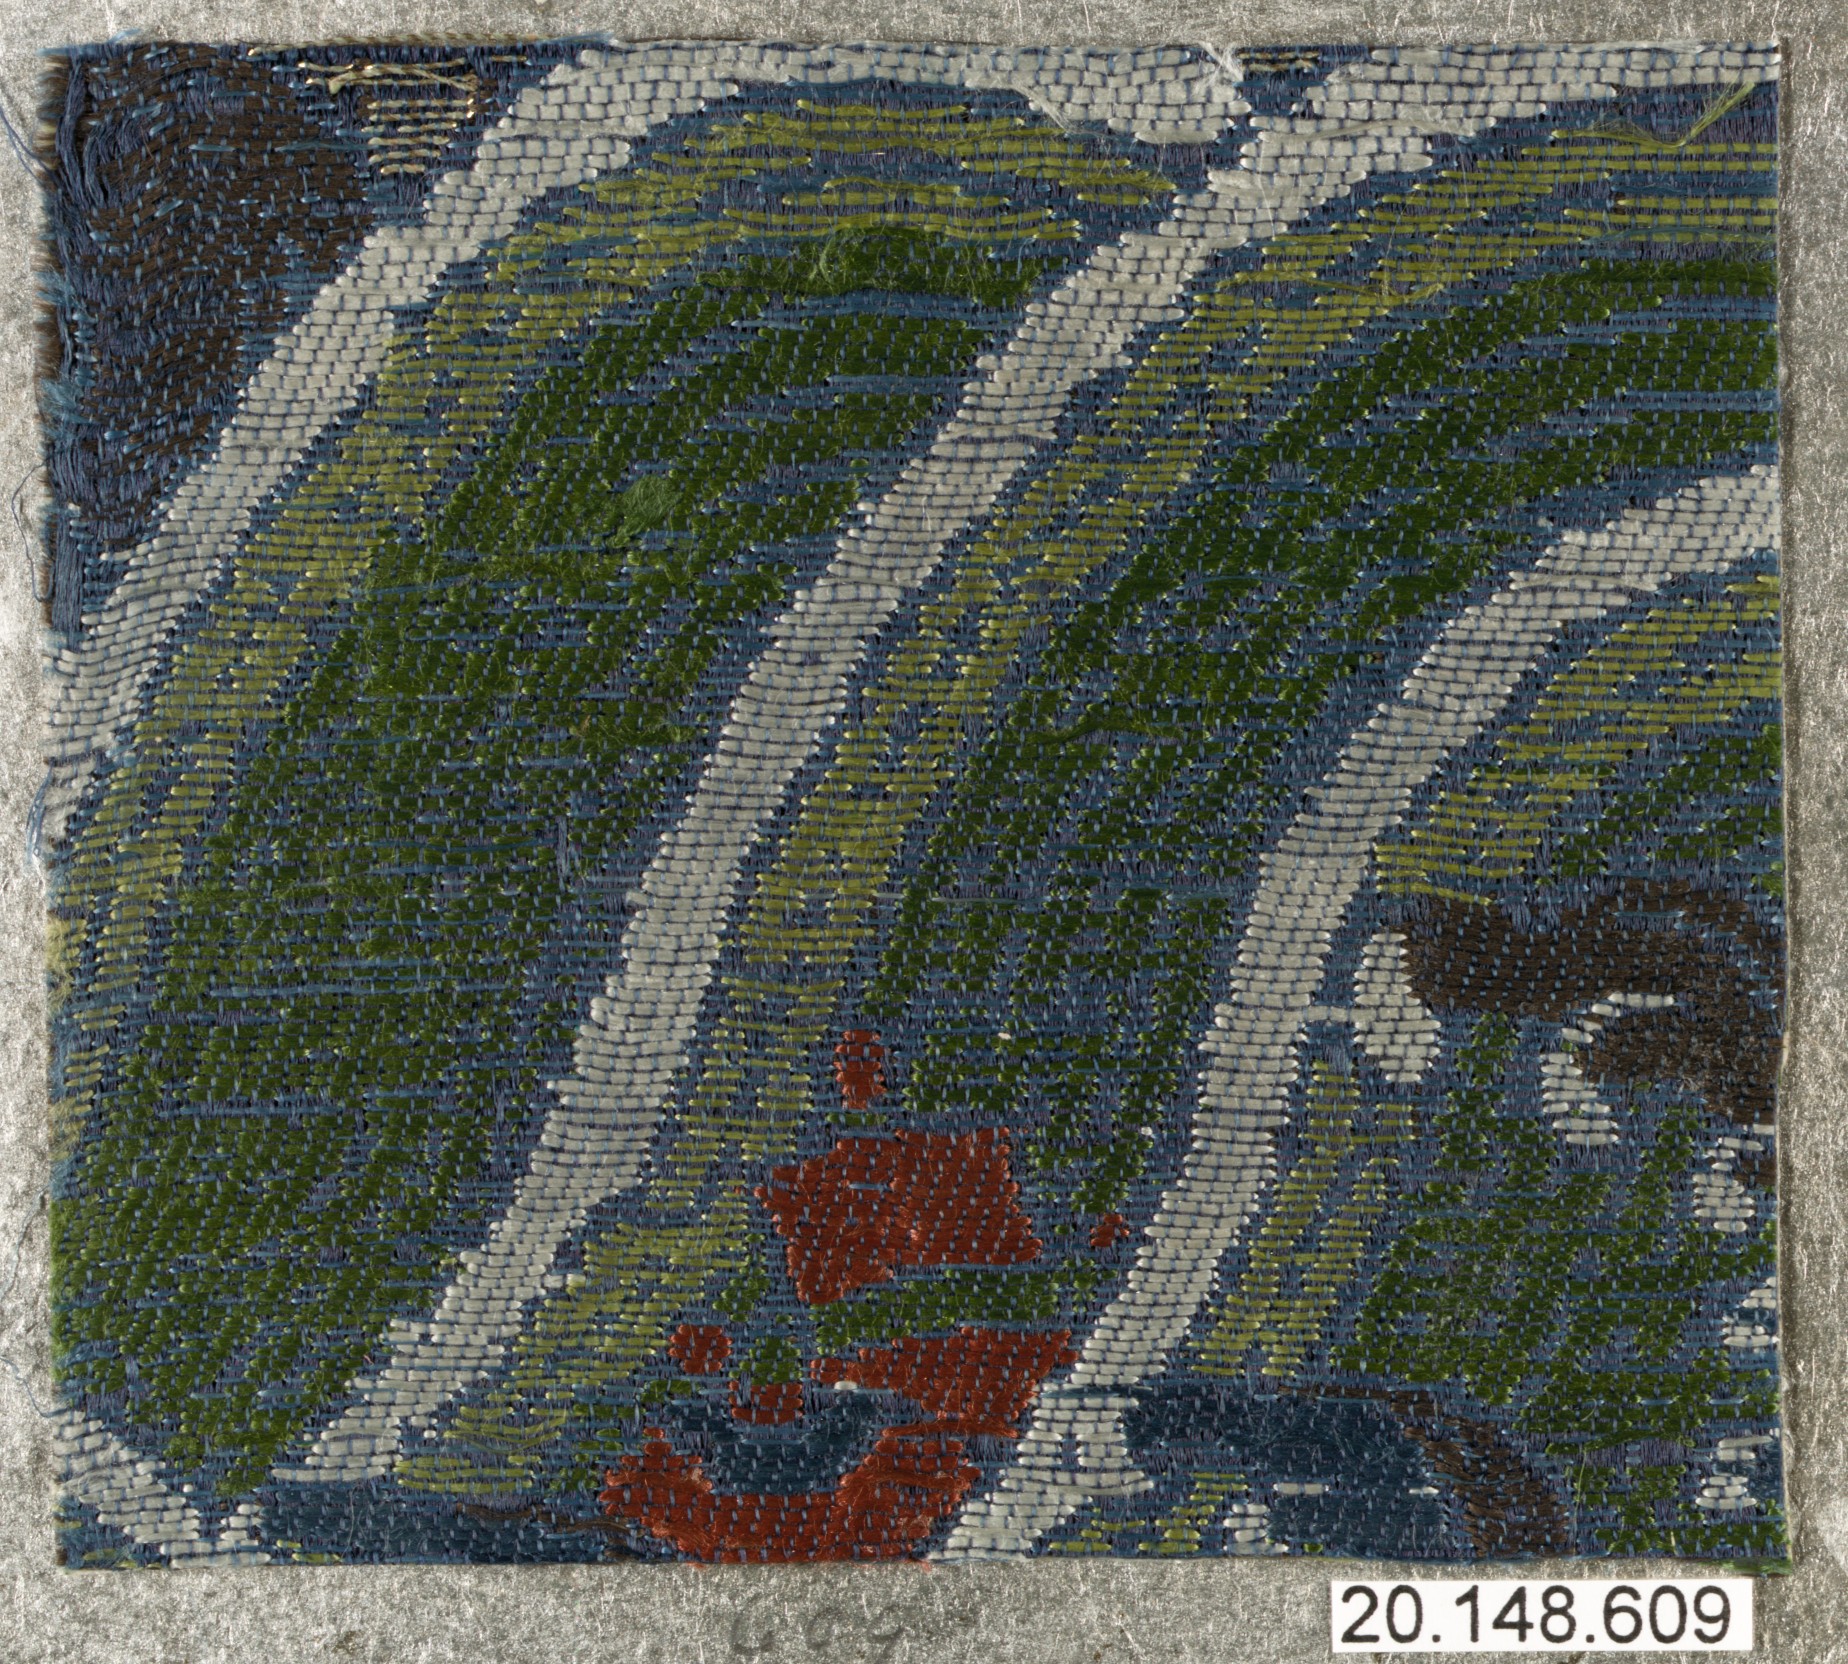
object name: piece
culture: chinese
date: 1701-1800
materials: silk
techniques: compound weave